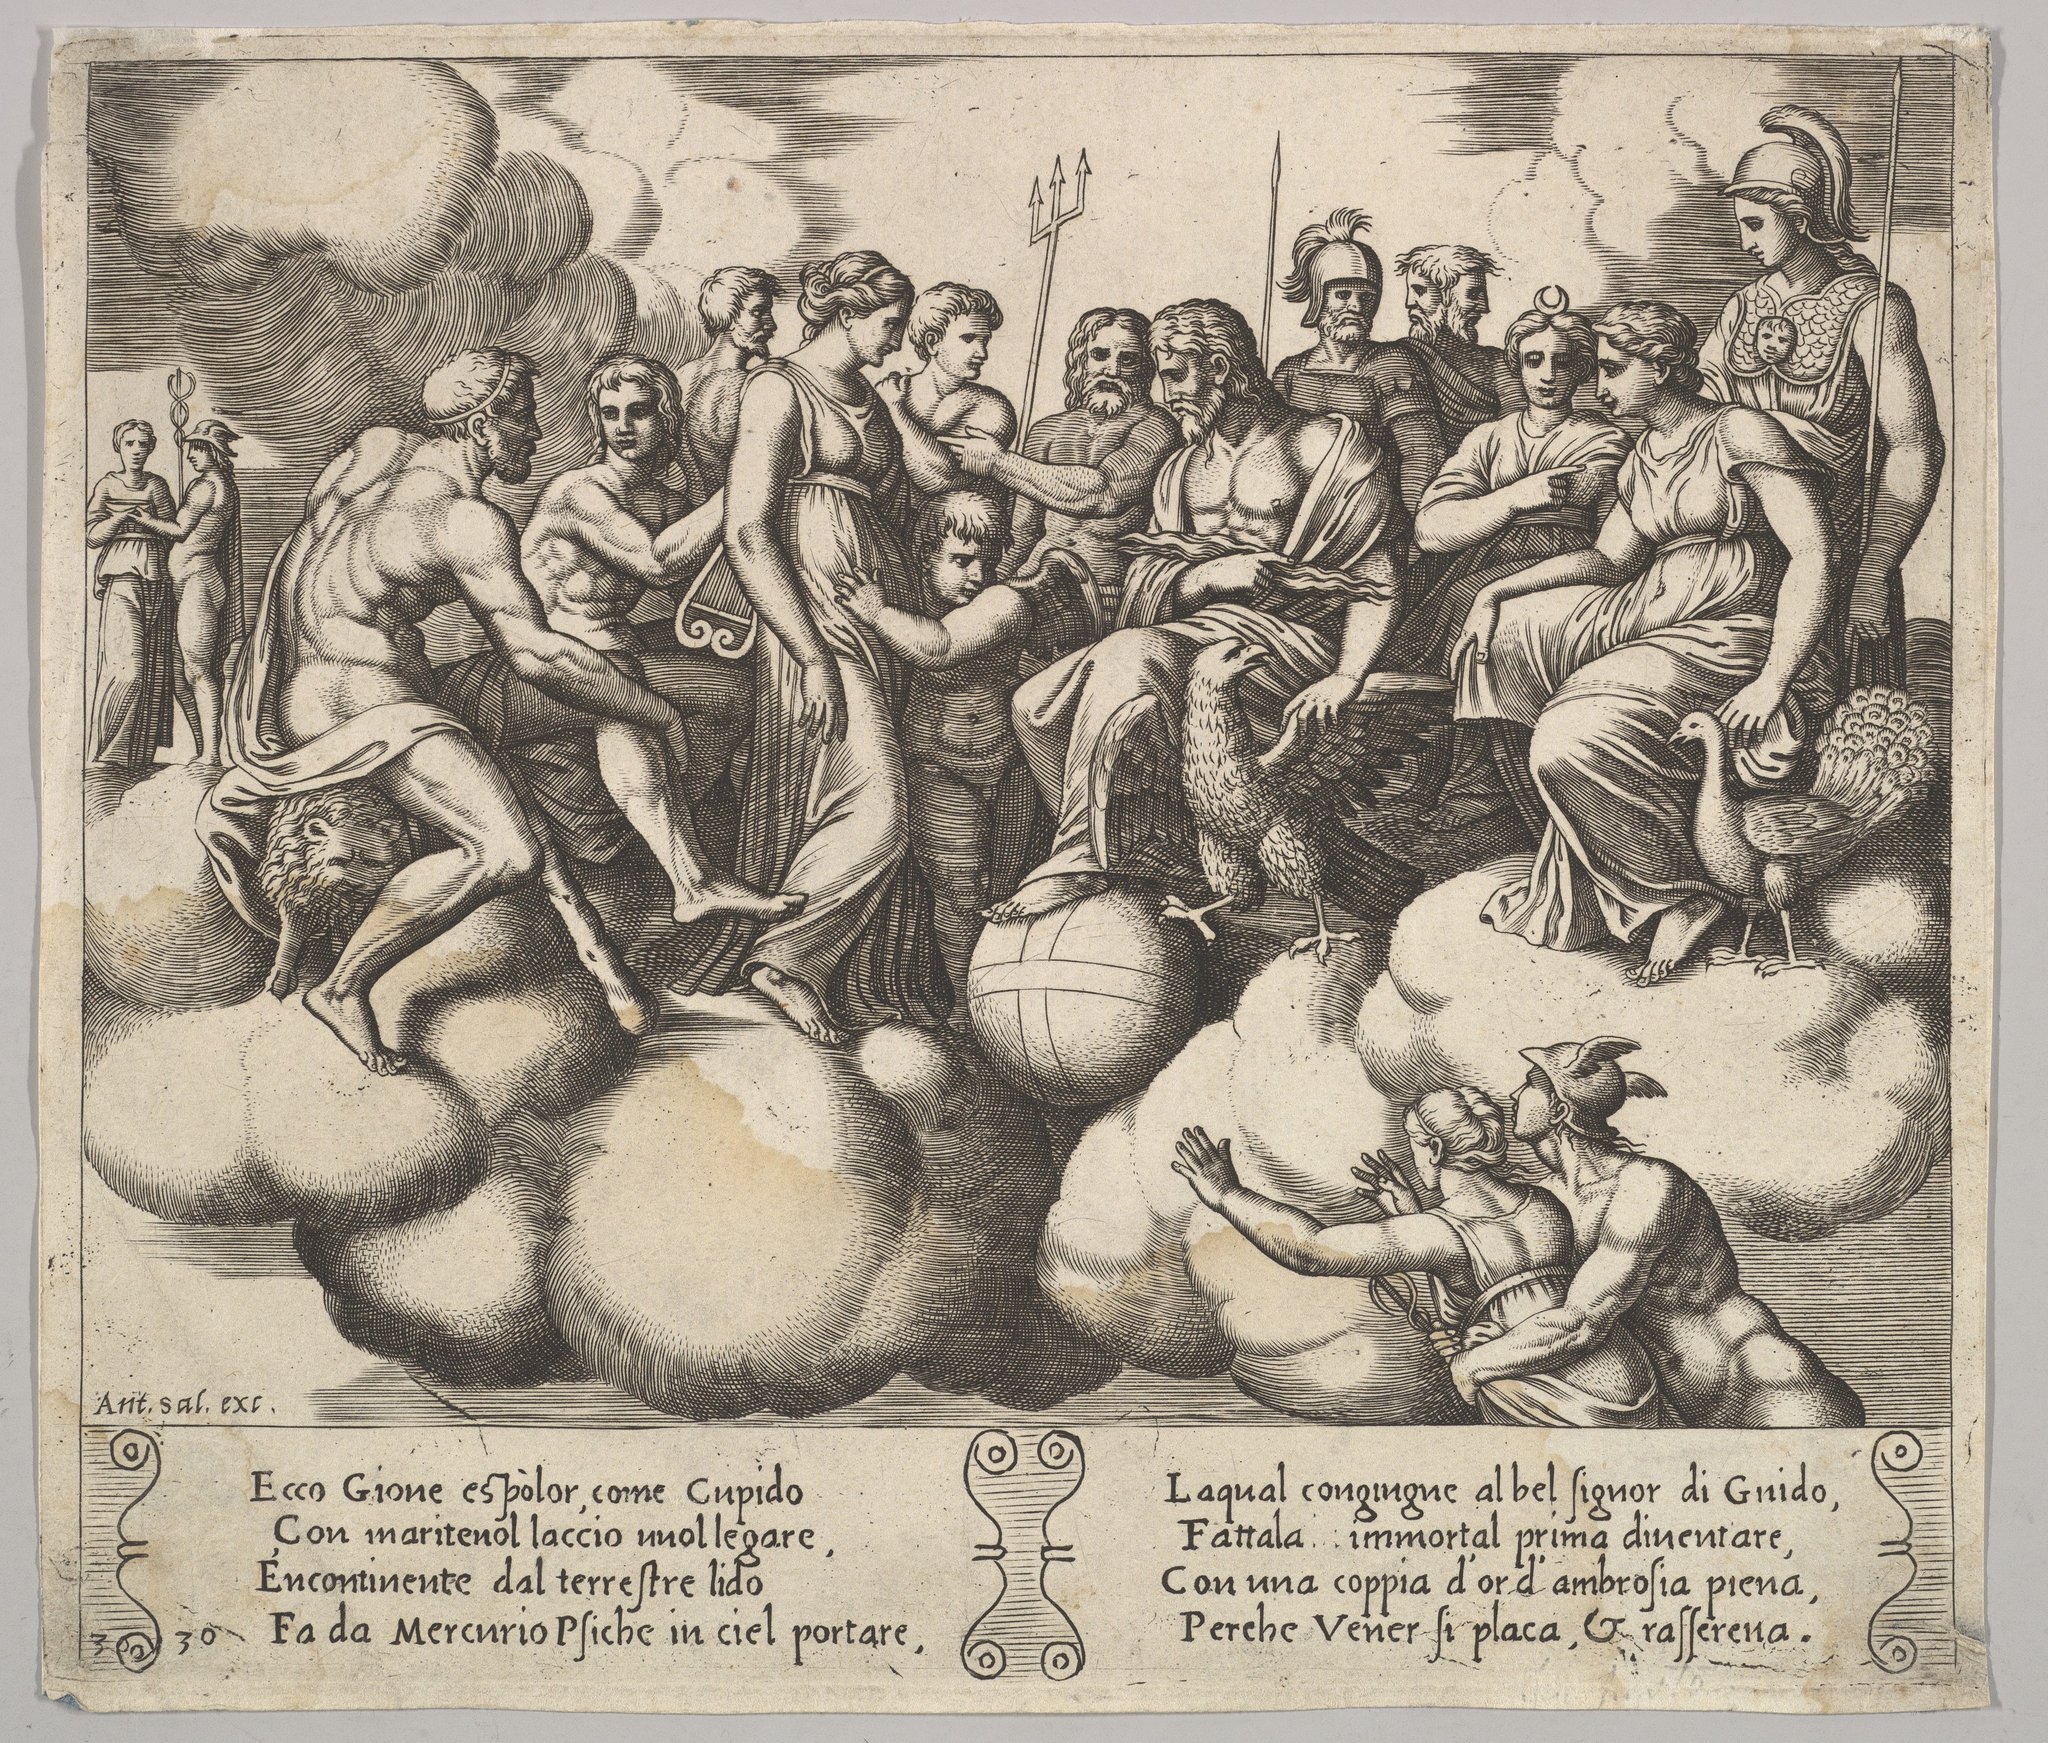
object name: print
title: Plate 30: Venus and Cupid pleading their case in the presence of Jupiter and other Gods, from "The Fable of Cupid and Psyche"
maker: master of the die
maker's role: artist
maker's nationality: italian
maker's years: 1525-1560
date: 1530-1560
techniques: engraving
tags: eagles,cupid,jupiter,venus,peacocks